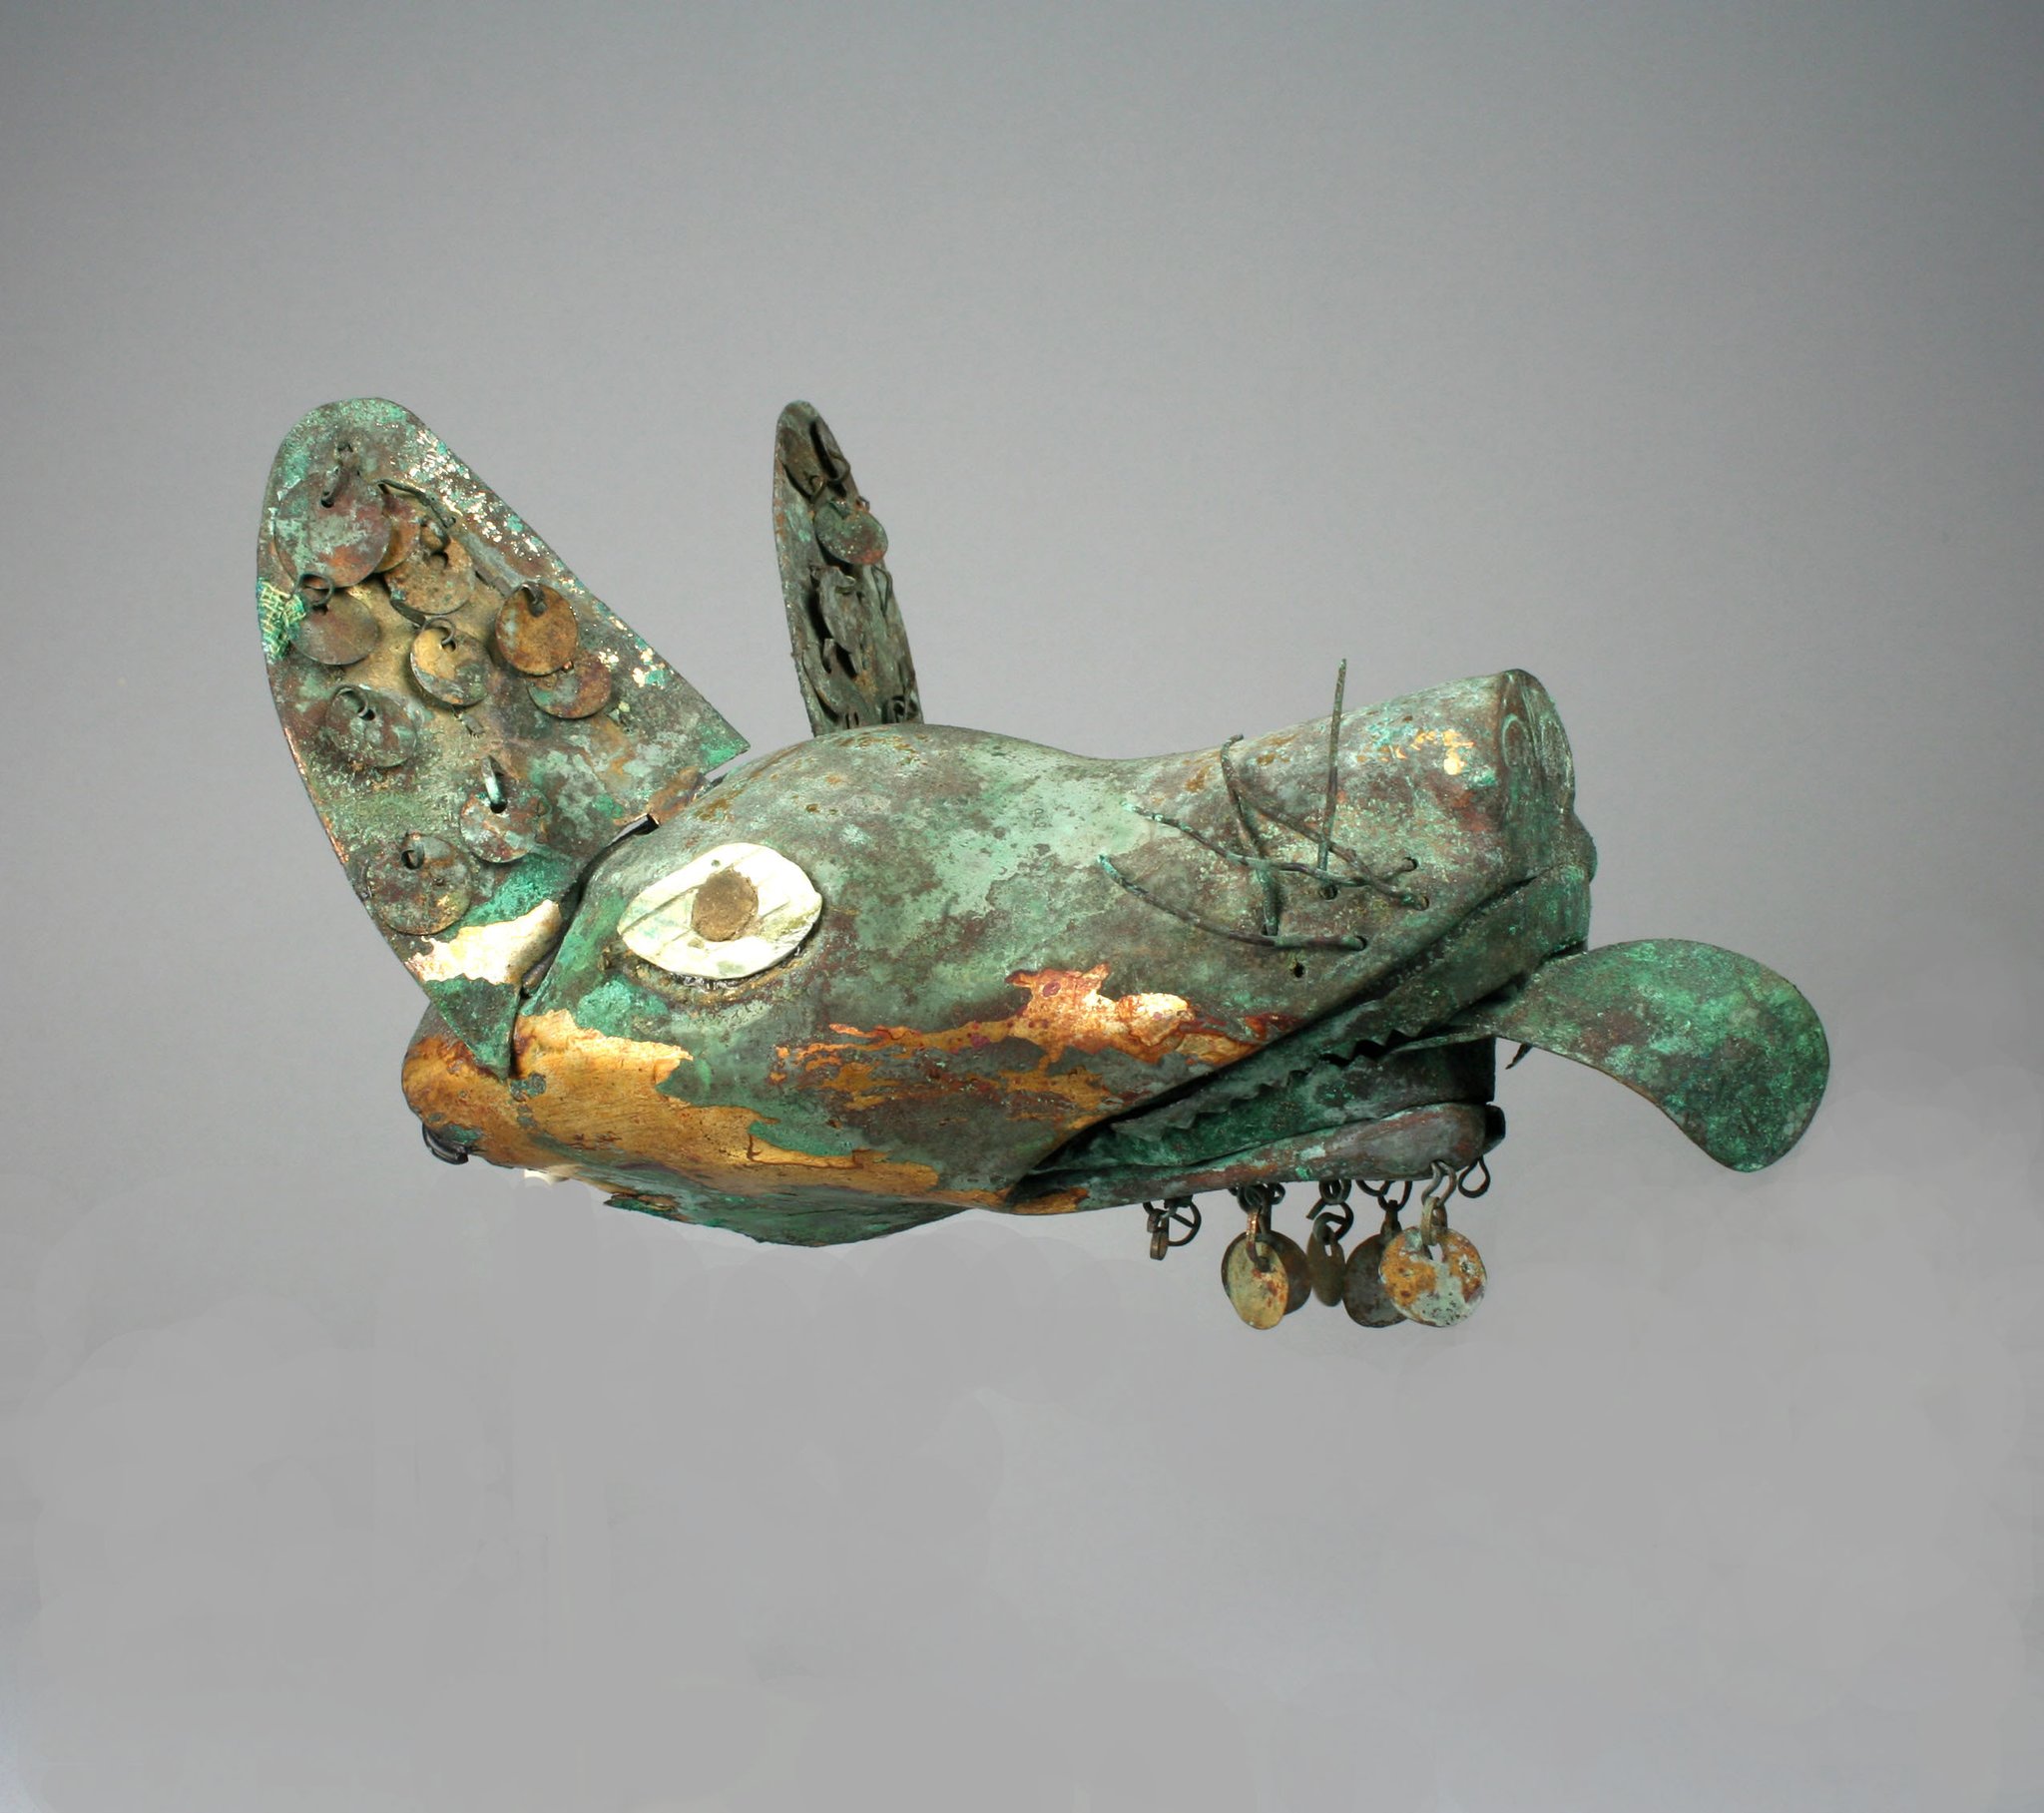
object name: ornament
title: Animal Ornament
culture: moche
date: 501-700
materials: copper, gilt copper, shell, metal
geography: peru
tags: animals